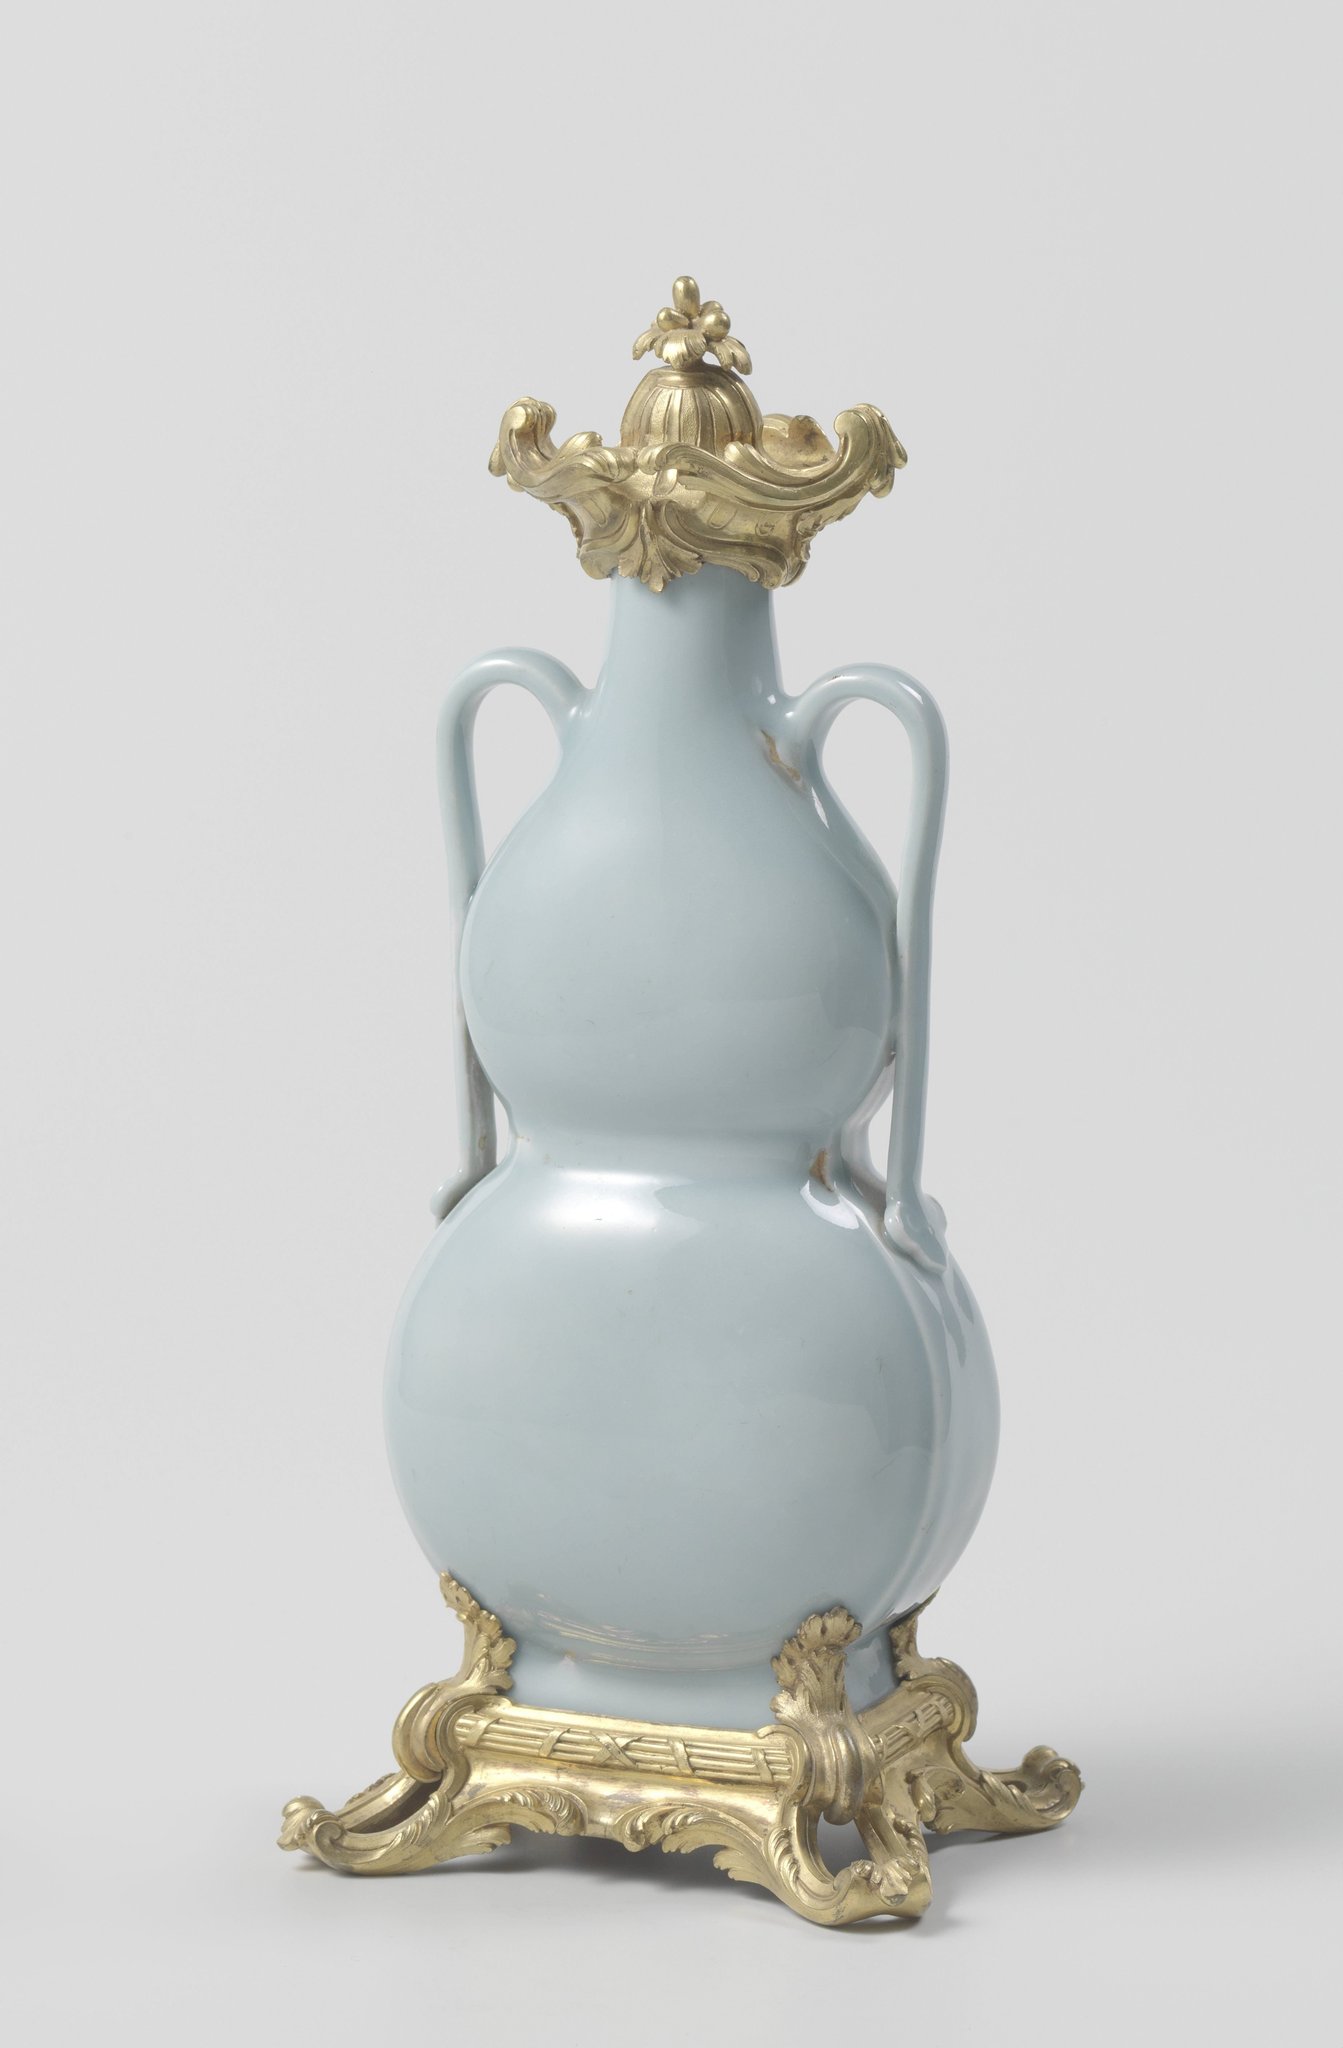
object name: vase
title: Pair of vases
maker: Anonymous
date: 1720-1750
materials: bronze, glaze, porcelain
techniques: gilding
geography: china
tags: ornaments ~ art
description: Originally made in China, these gourd vases were fitted in Paris with fashionable gilt-bronze mounts, with pagoda-shaped lids. In this way the French craftsman adapted an exotic object to Western taste. With their gilding, the vases matched the other furnishings in a luxuriously appointed interior.